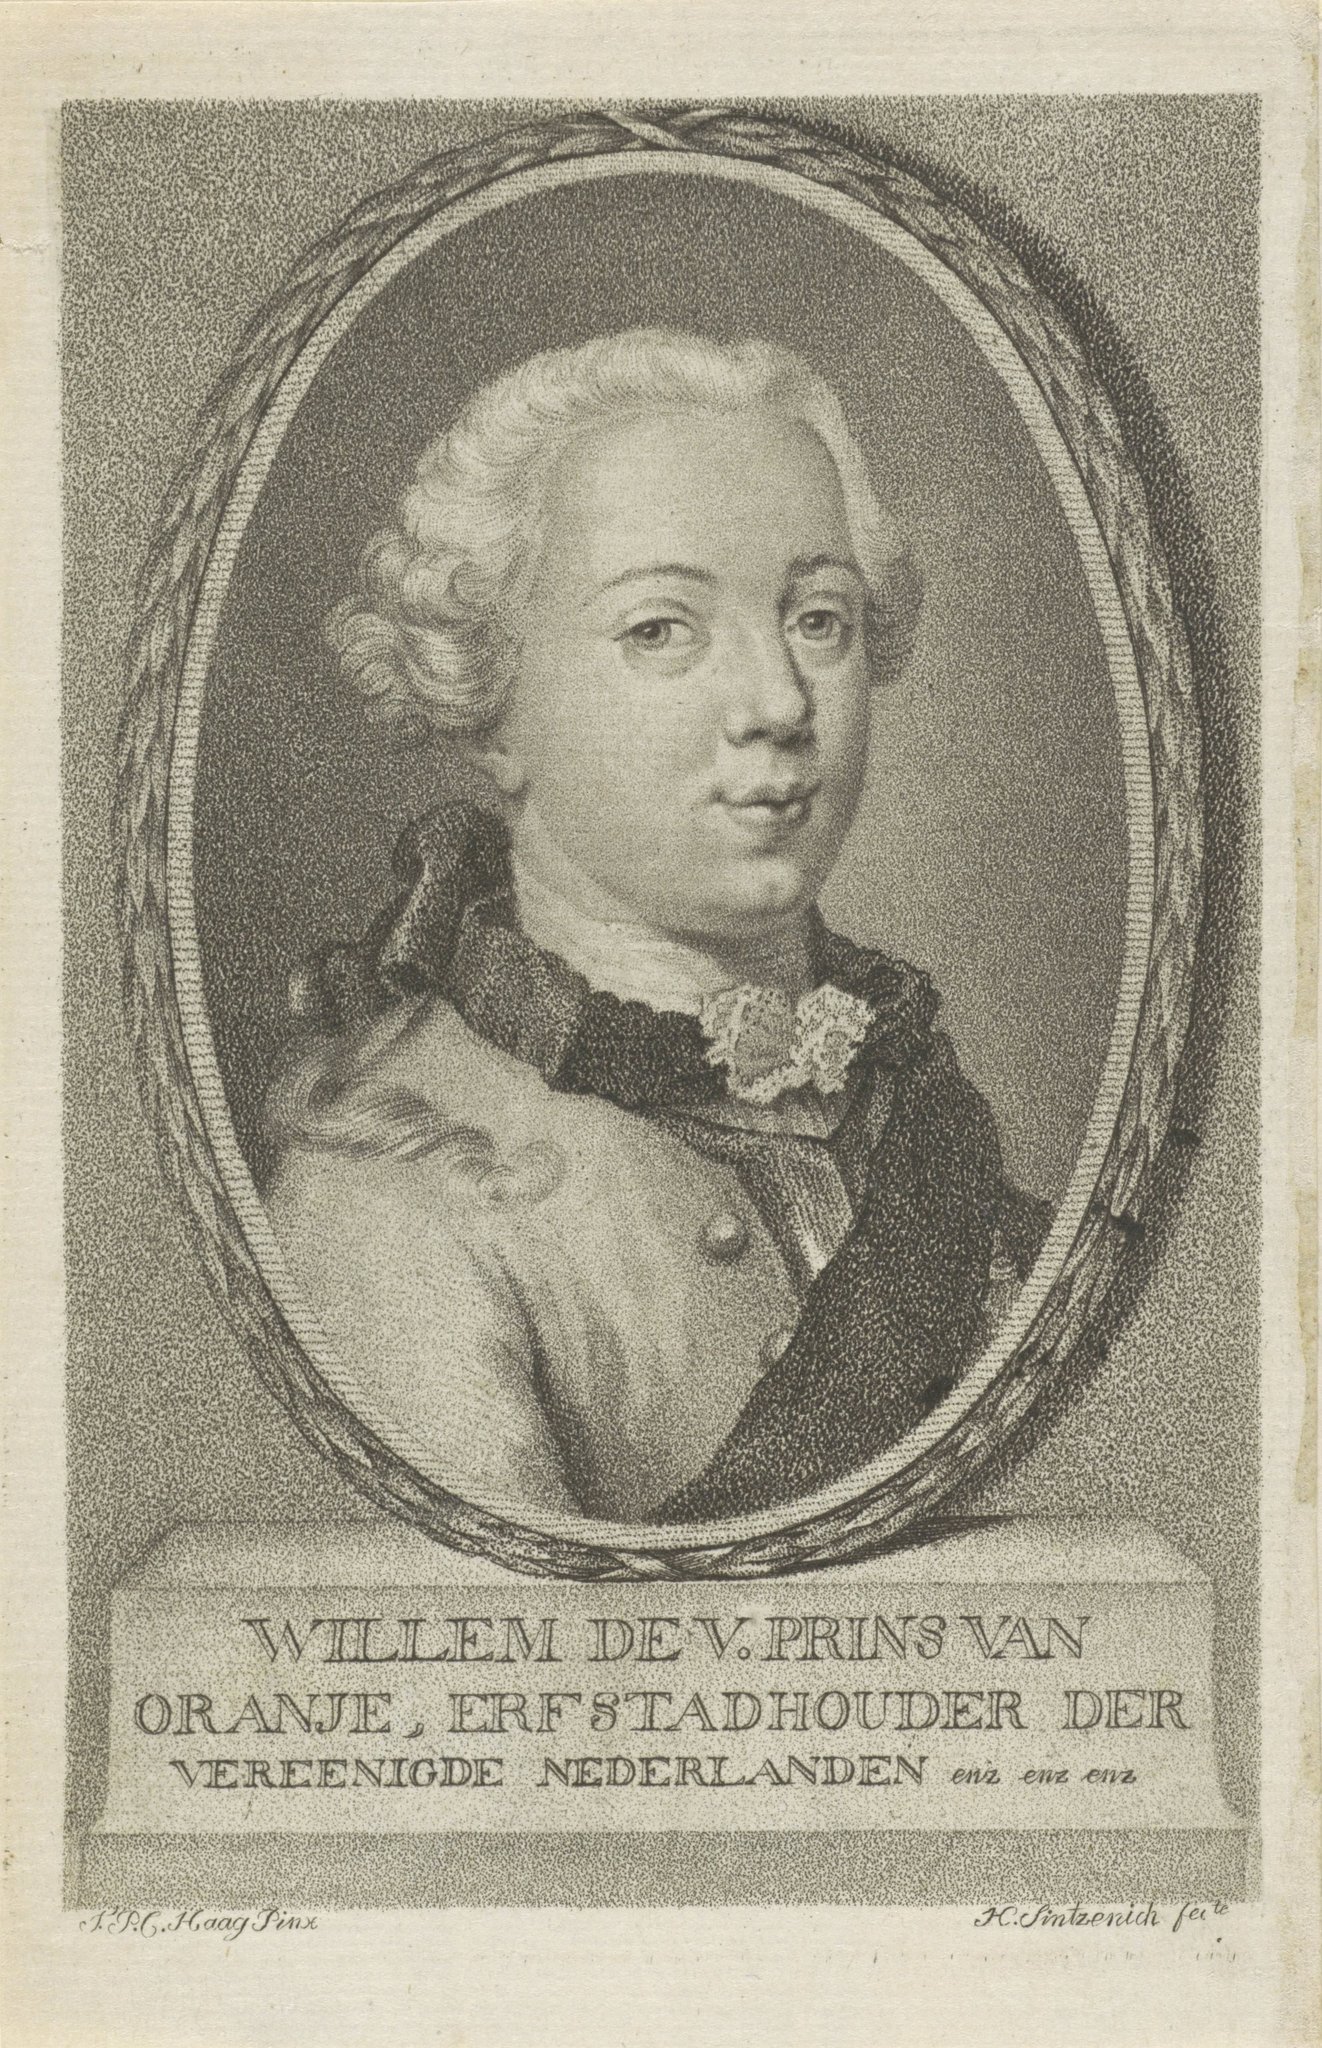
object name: print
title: Portret van Willem V, prins van Oranje-Nassau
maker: tethart philip christian haag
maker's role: draughtsman, print maker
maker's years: 1737-1812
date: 1775-1802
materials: paper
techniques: engraving, etching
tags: the hague, william v (prince of orange)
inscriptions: collector's mark: Lugt 2228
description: De hier vermelde titel verwijst naar de hoogst verkregen titel van de geportretteerde, niet per se naar de titel die de geportretteerde op deze voorstelling draagt.